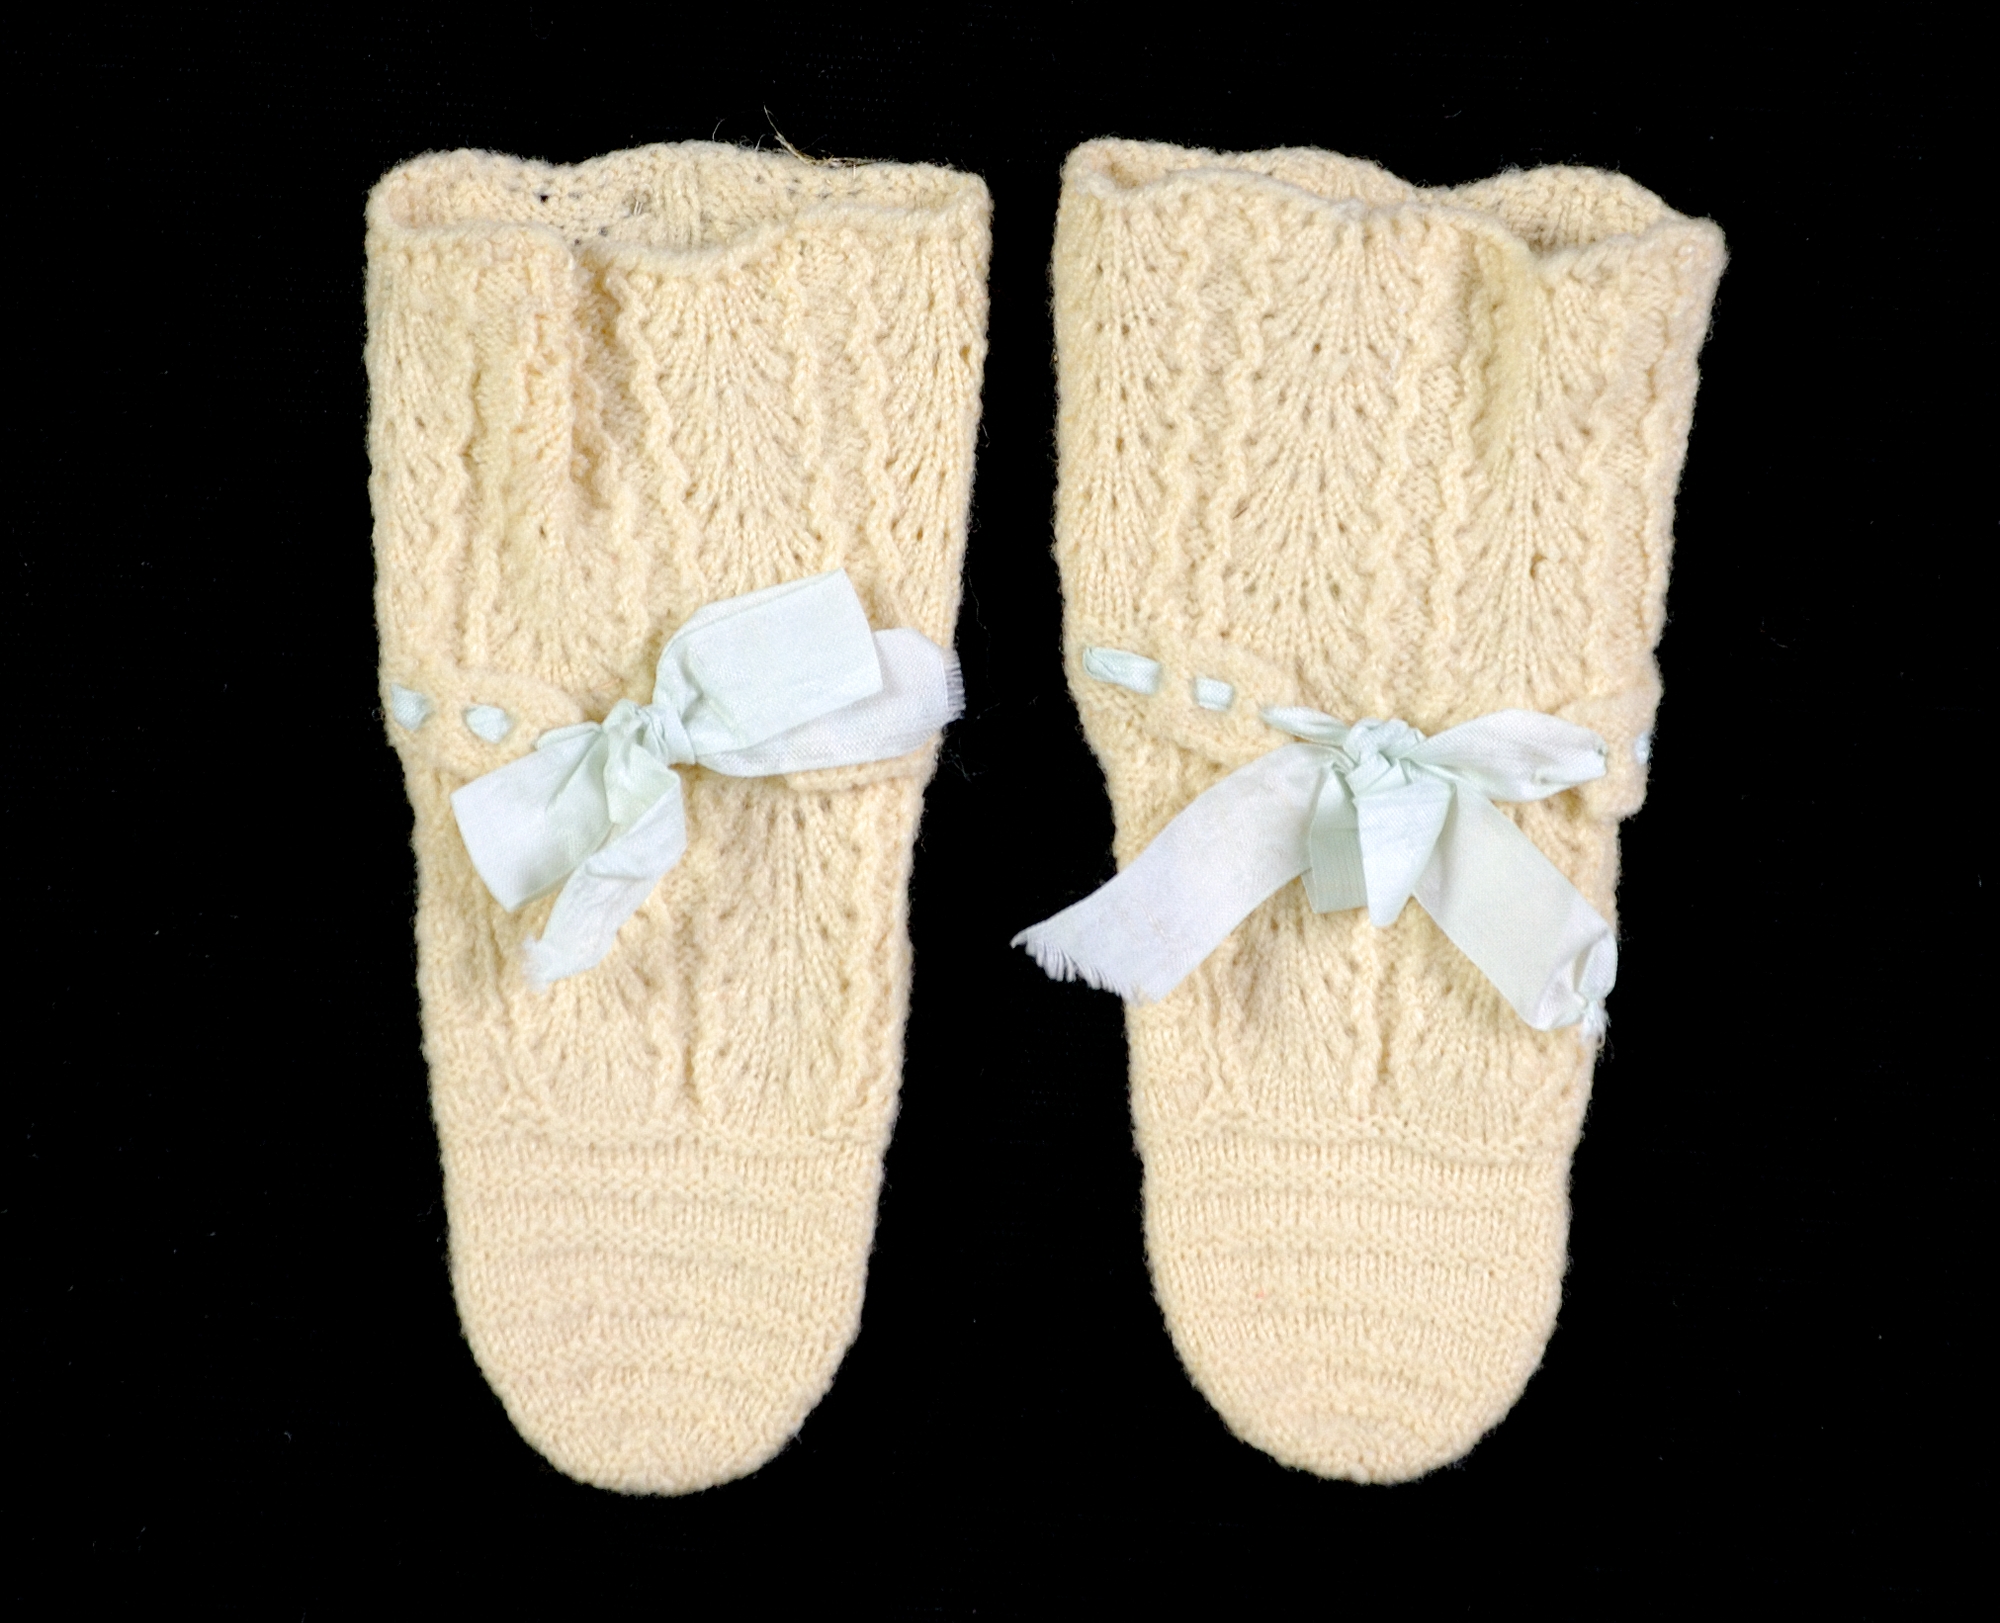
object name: bootee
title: Bootees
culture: american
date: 1840-1860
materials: silk, wool